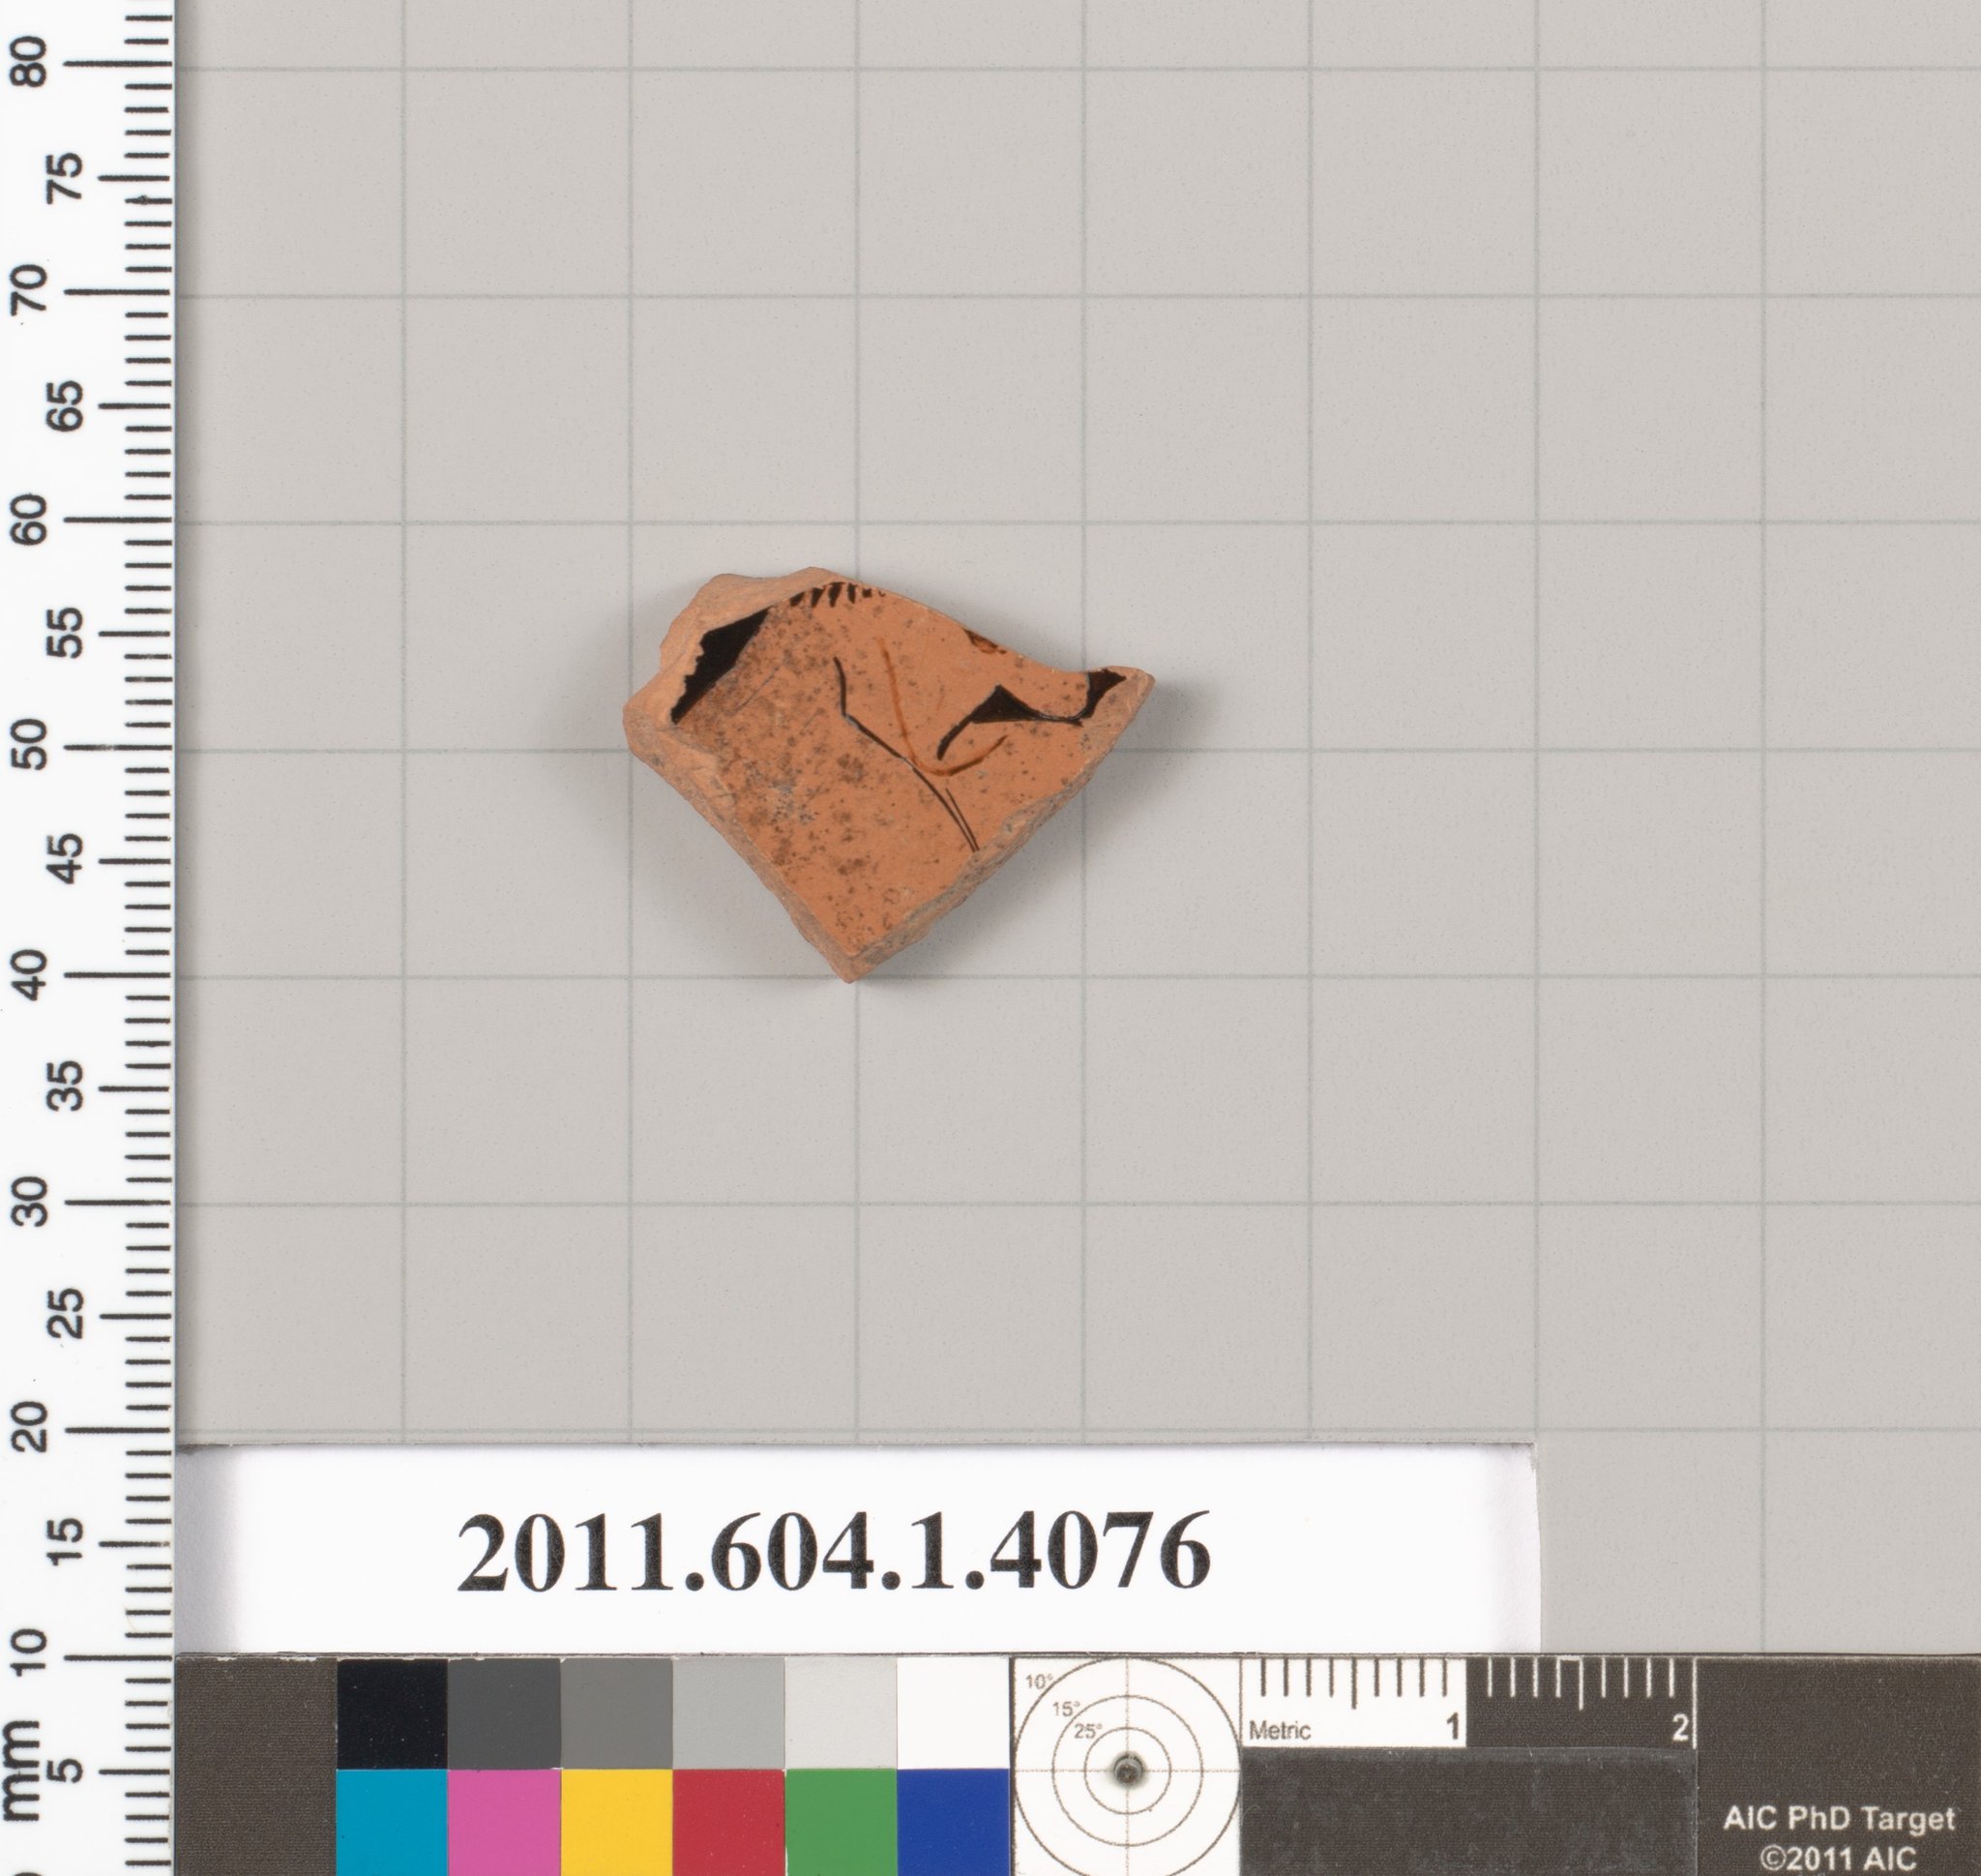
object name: kylix fragment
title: Terracotta fragment of a kylix (drinking cup)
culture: greek, attic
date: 490-470 BCE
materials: terracotta